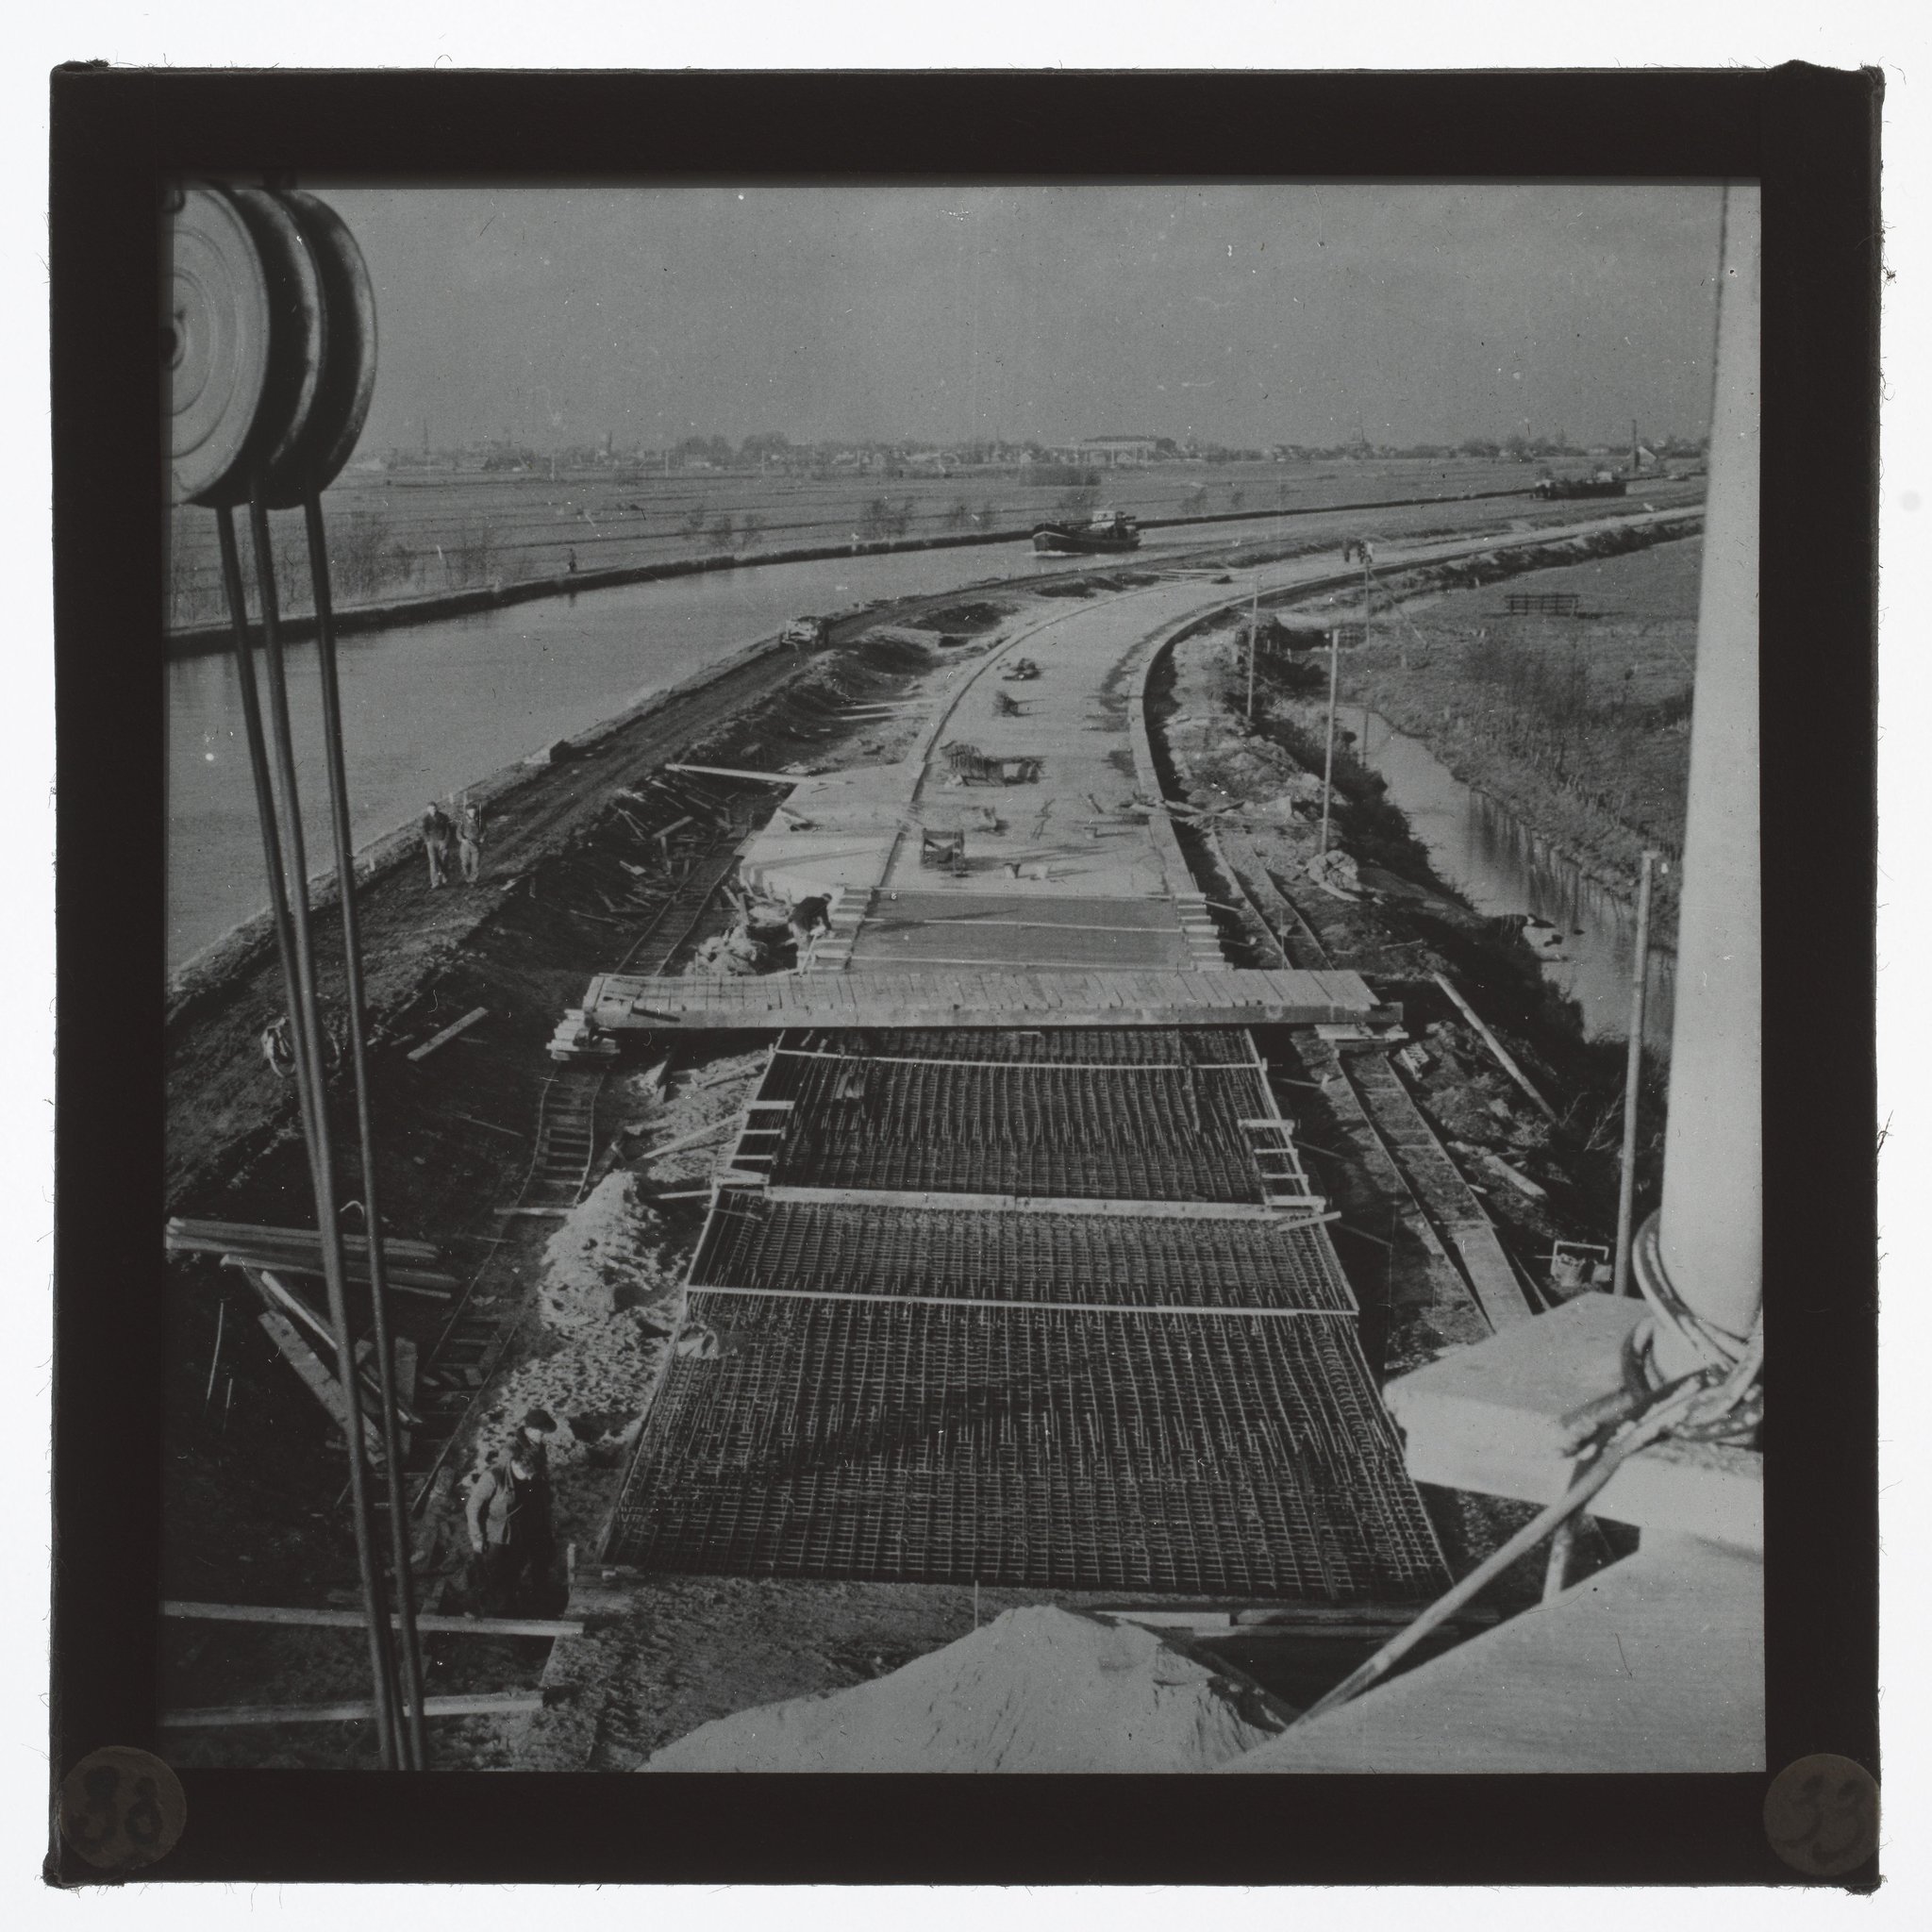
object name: lantern slide photographic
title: Gezicht op een weg in aanbouw, Zuid-Holland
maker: Anonymous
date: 1956-1960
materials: glass, paper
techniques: gelatin silver transparency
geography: south holland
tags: building-site, public road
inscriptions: number: ‘33’